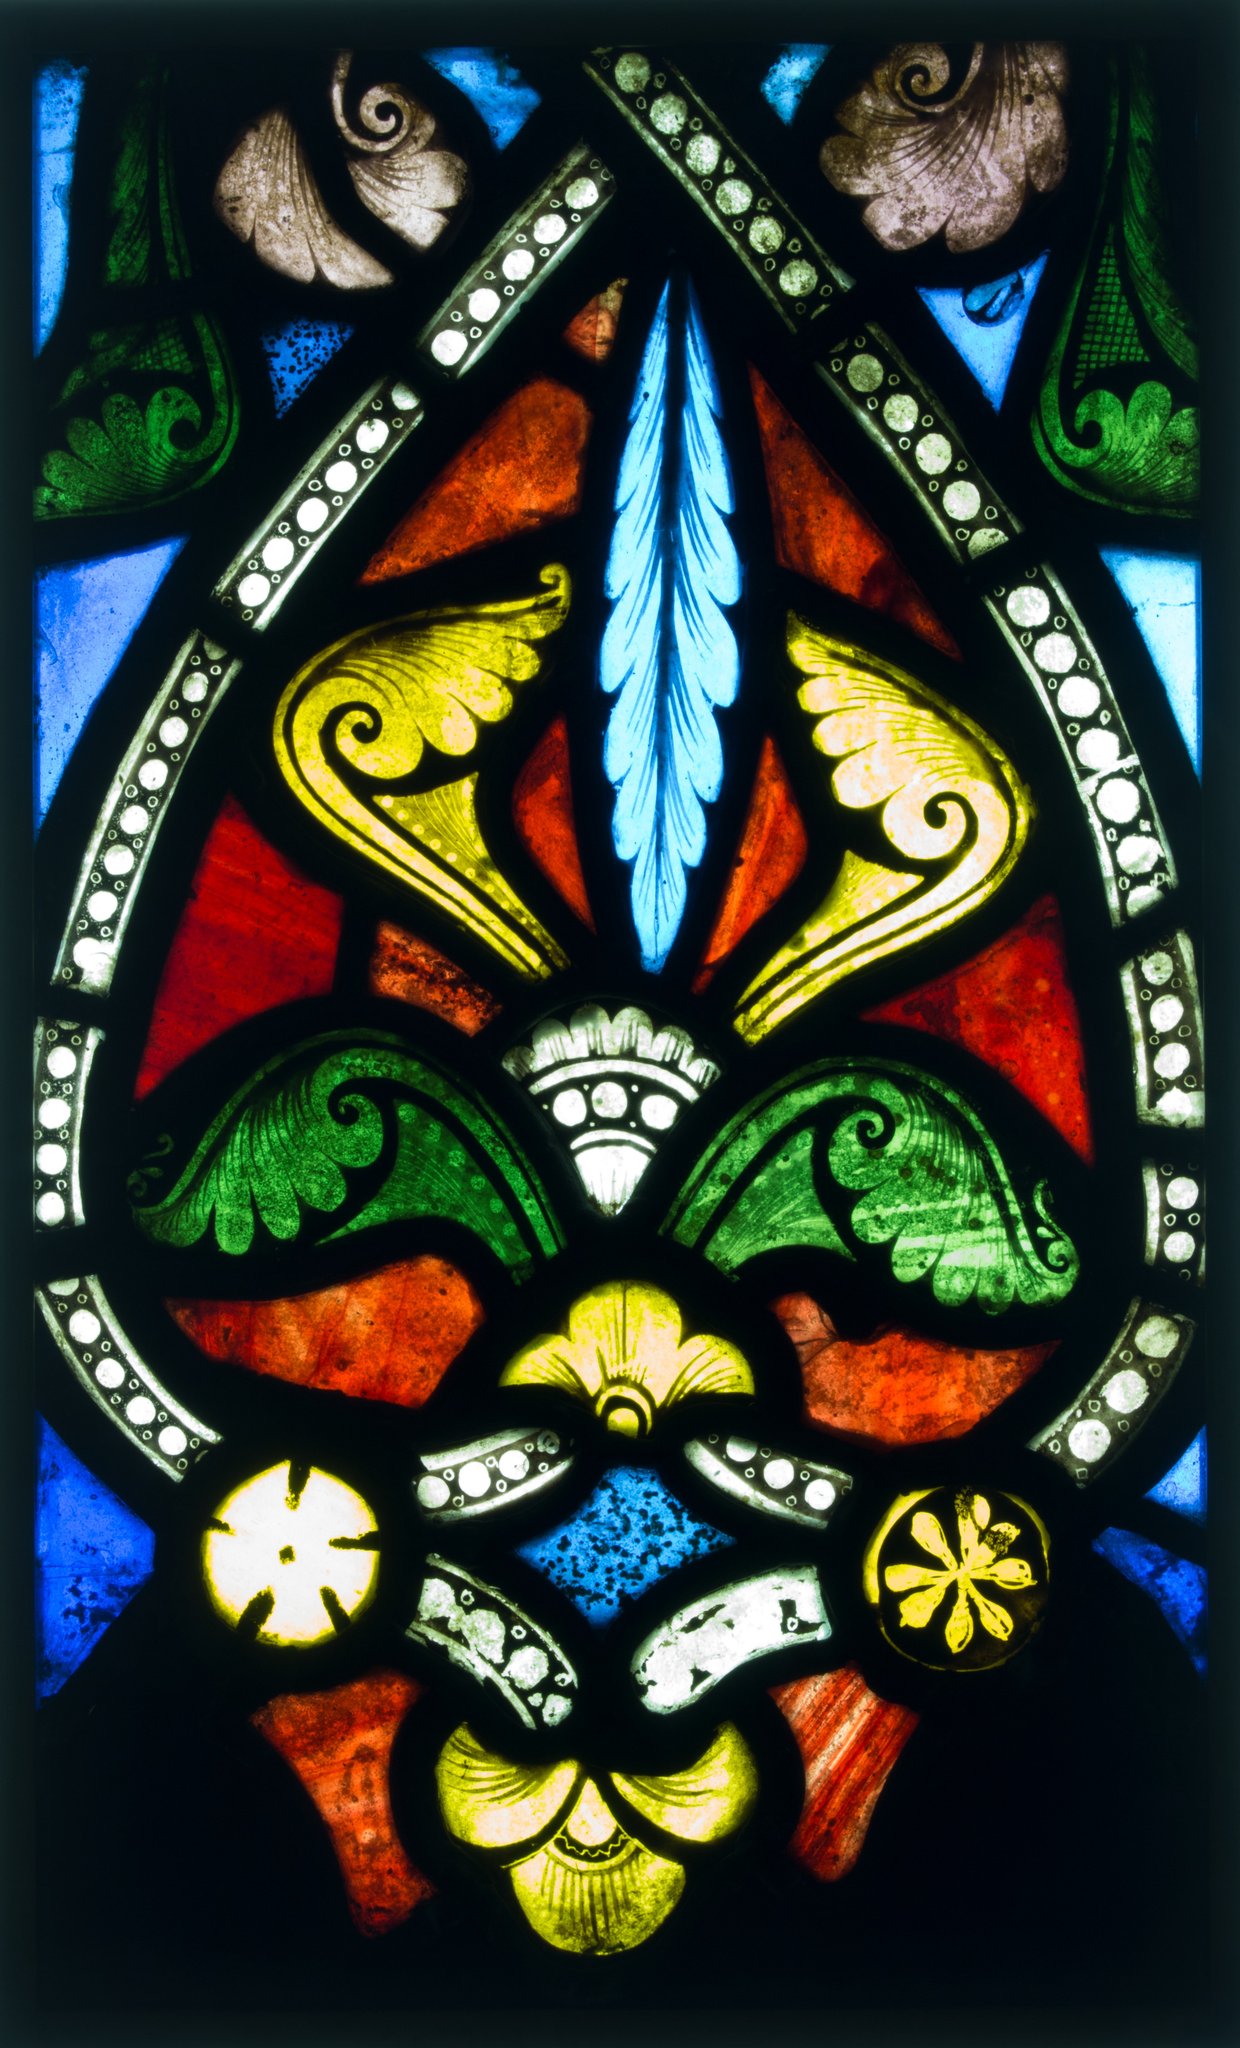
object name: fragment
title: Foliate Border Section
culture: french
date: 1140-1144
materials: glass, lead, metal, paint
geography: france